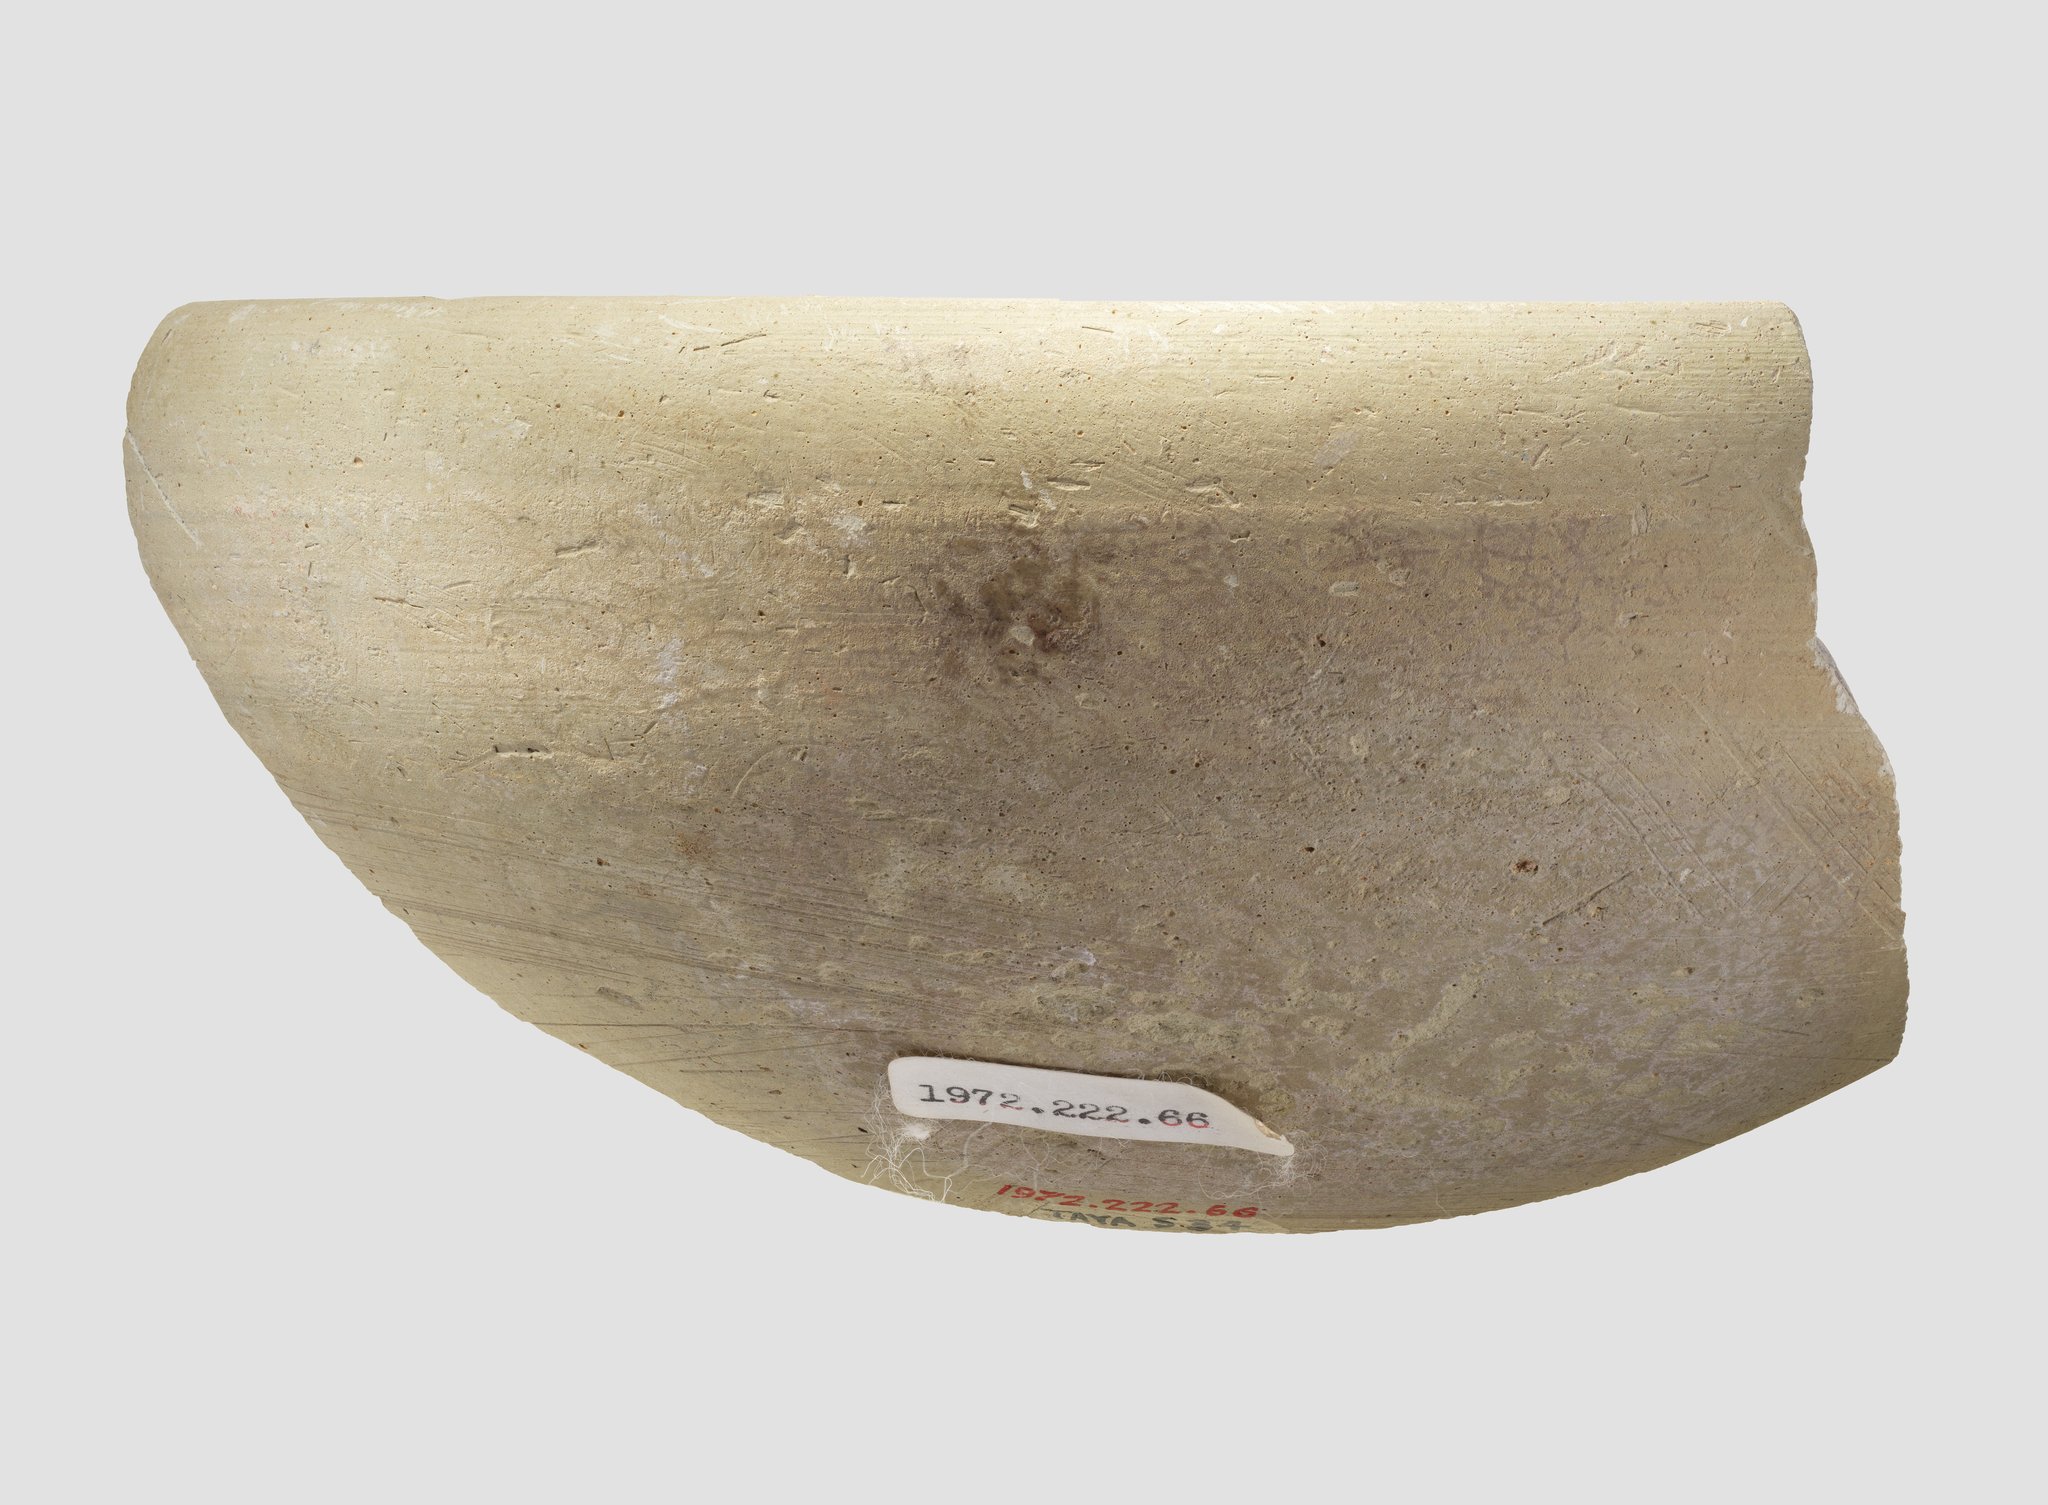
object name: bowl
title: Bowl sherd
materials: ceramic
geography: mesopotamia